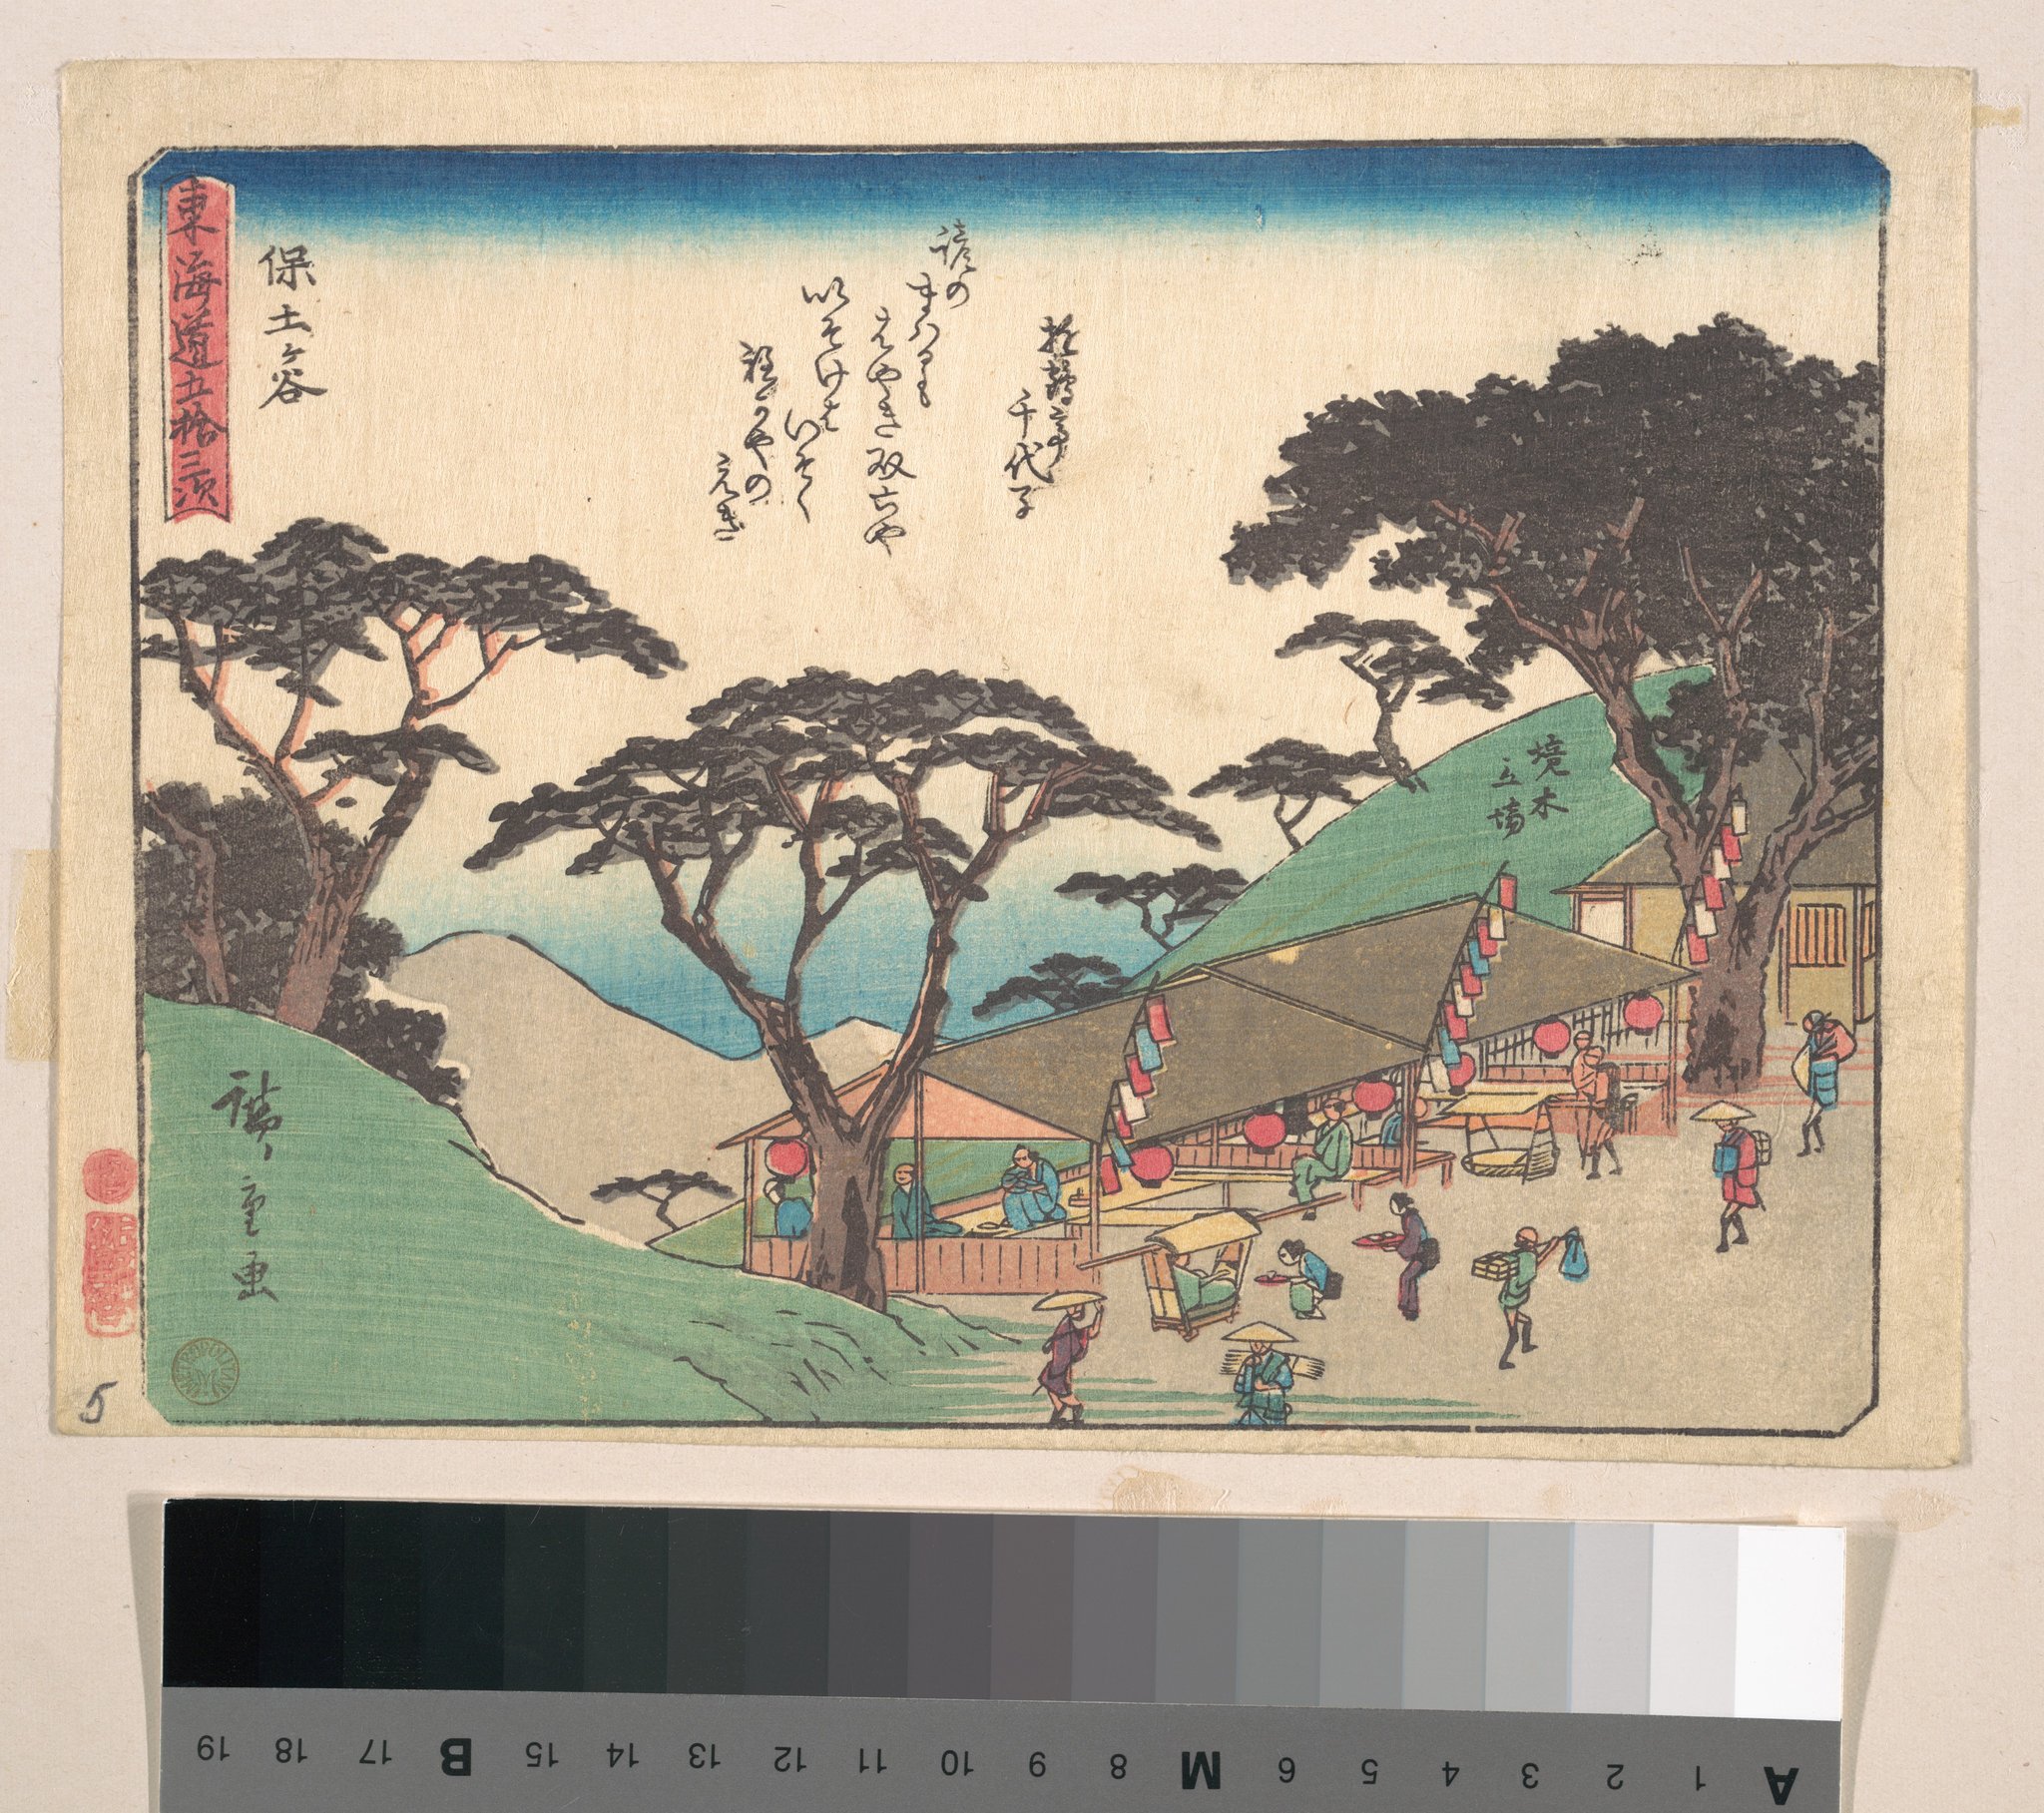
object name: print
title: Hodogaya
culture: japanese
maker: utagawa hiroshige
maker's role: artist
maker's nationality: japanese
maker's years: 1797-1858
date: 1838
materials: ink, paper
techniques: woodblock print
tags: human figures